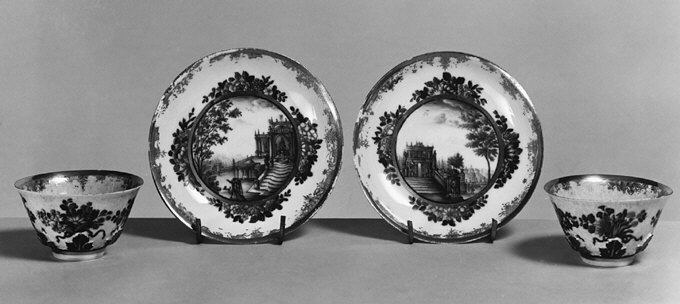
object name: teabowl and saucer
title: Pair of teabowls and saucers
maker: meissen manufactory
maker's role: manufactory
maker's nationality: german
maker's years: 1710-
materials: hard paste porcelain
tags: buildings,flowers,trees